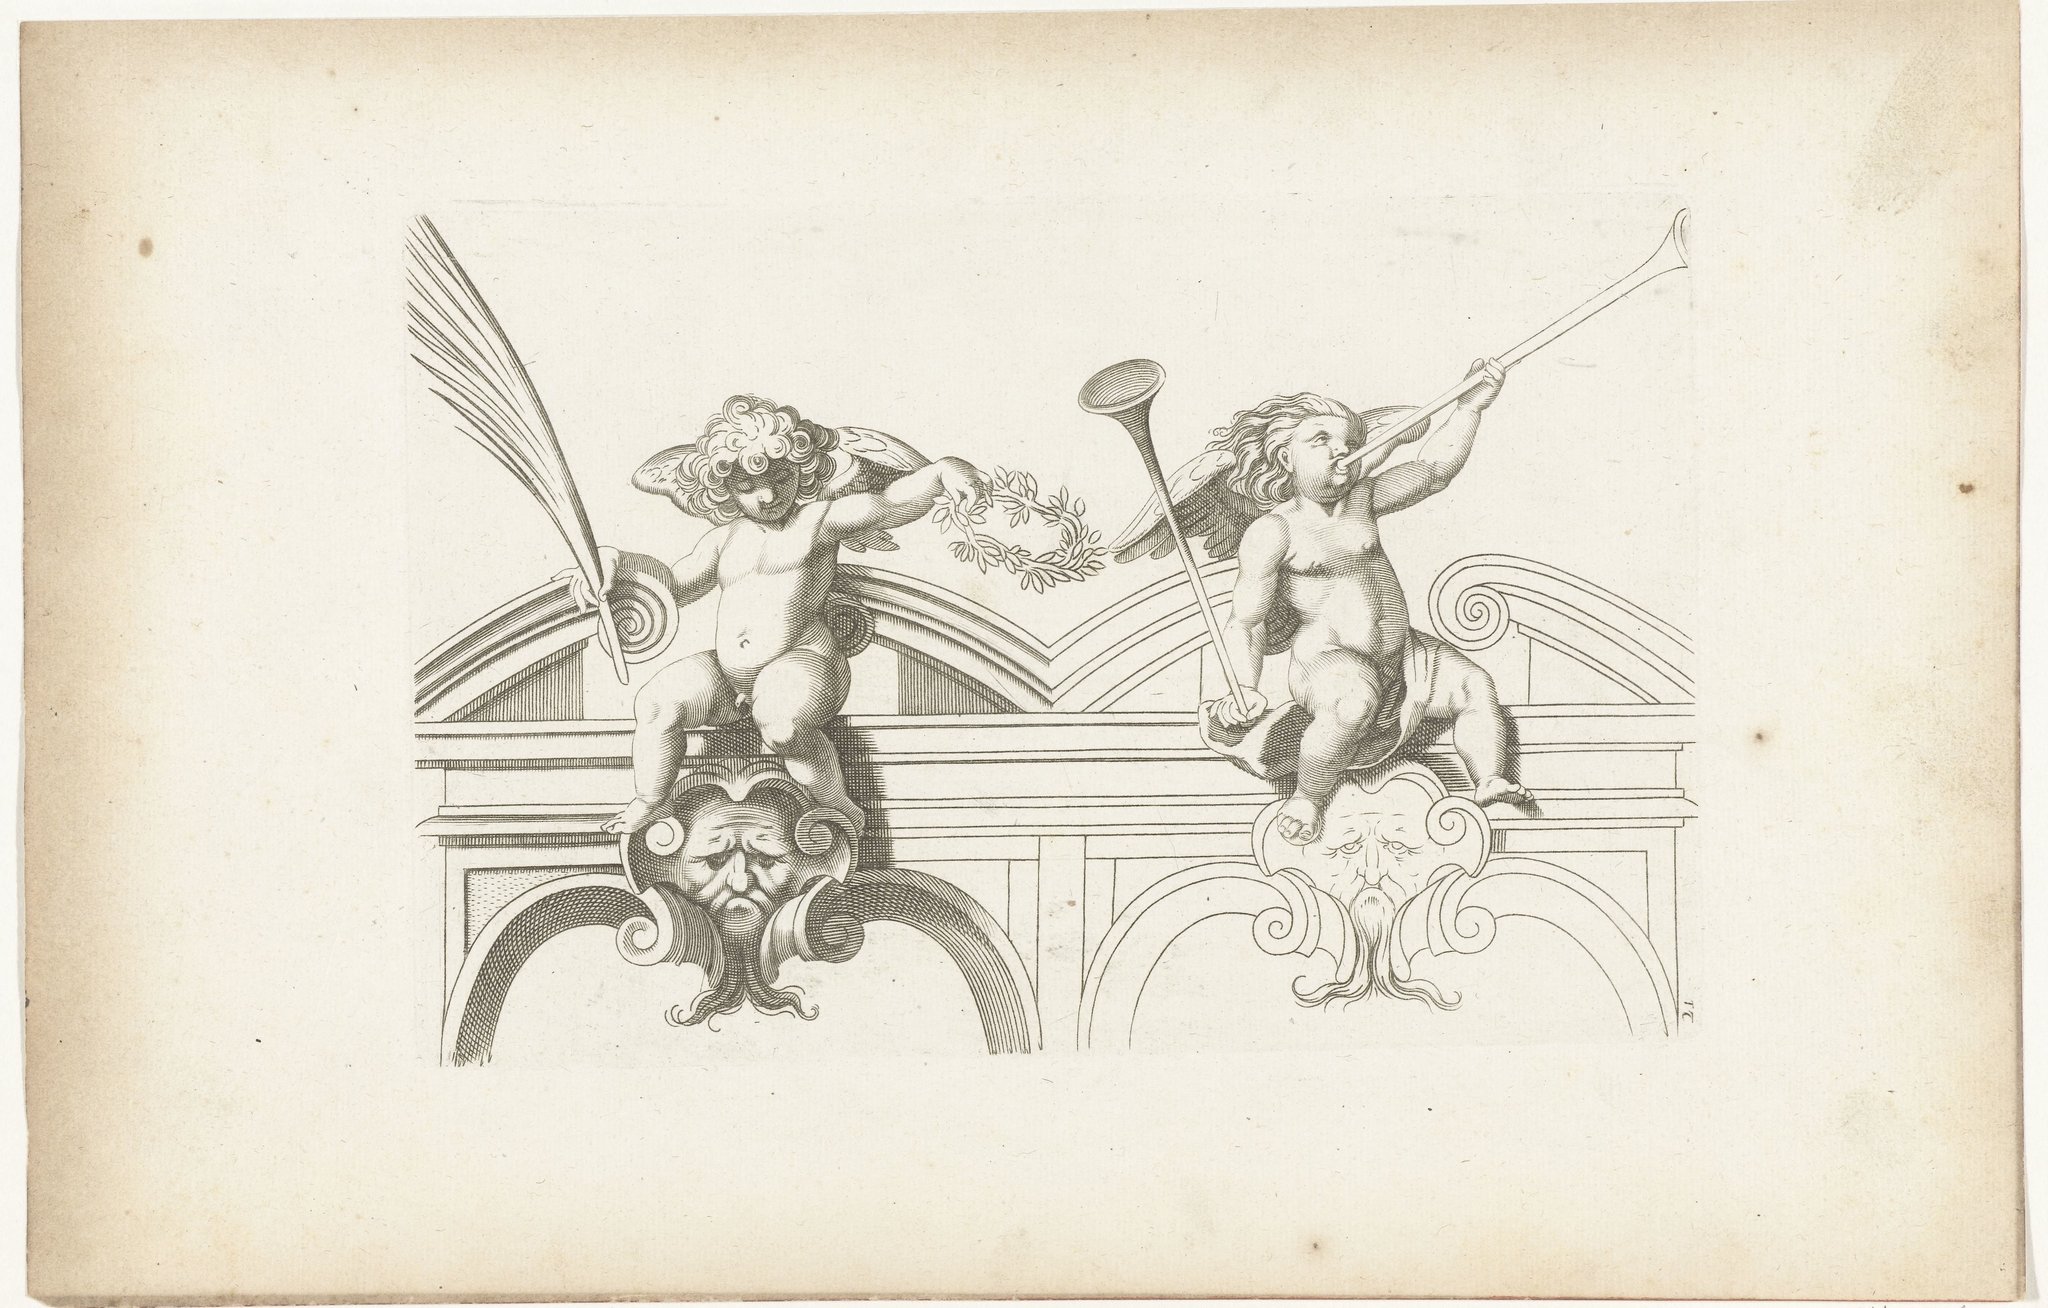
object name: print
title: Twee putti zittend voor frontons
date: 1613-1657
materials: paper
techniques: engraving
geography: france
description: De putto links heeft een palmtak en een lauwerkrans vast, de putto rechts twee bazuinen.